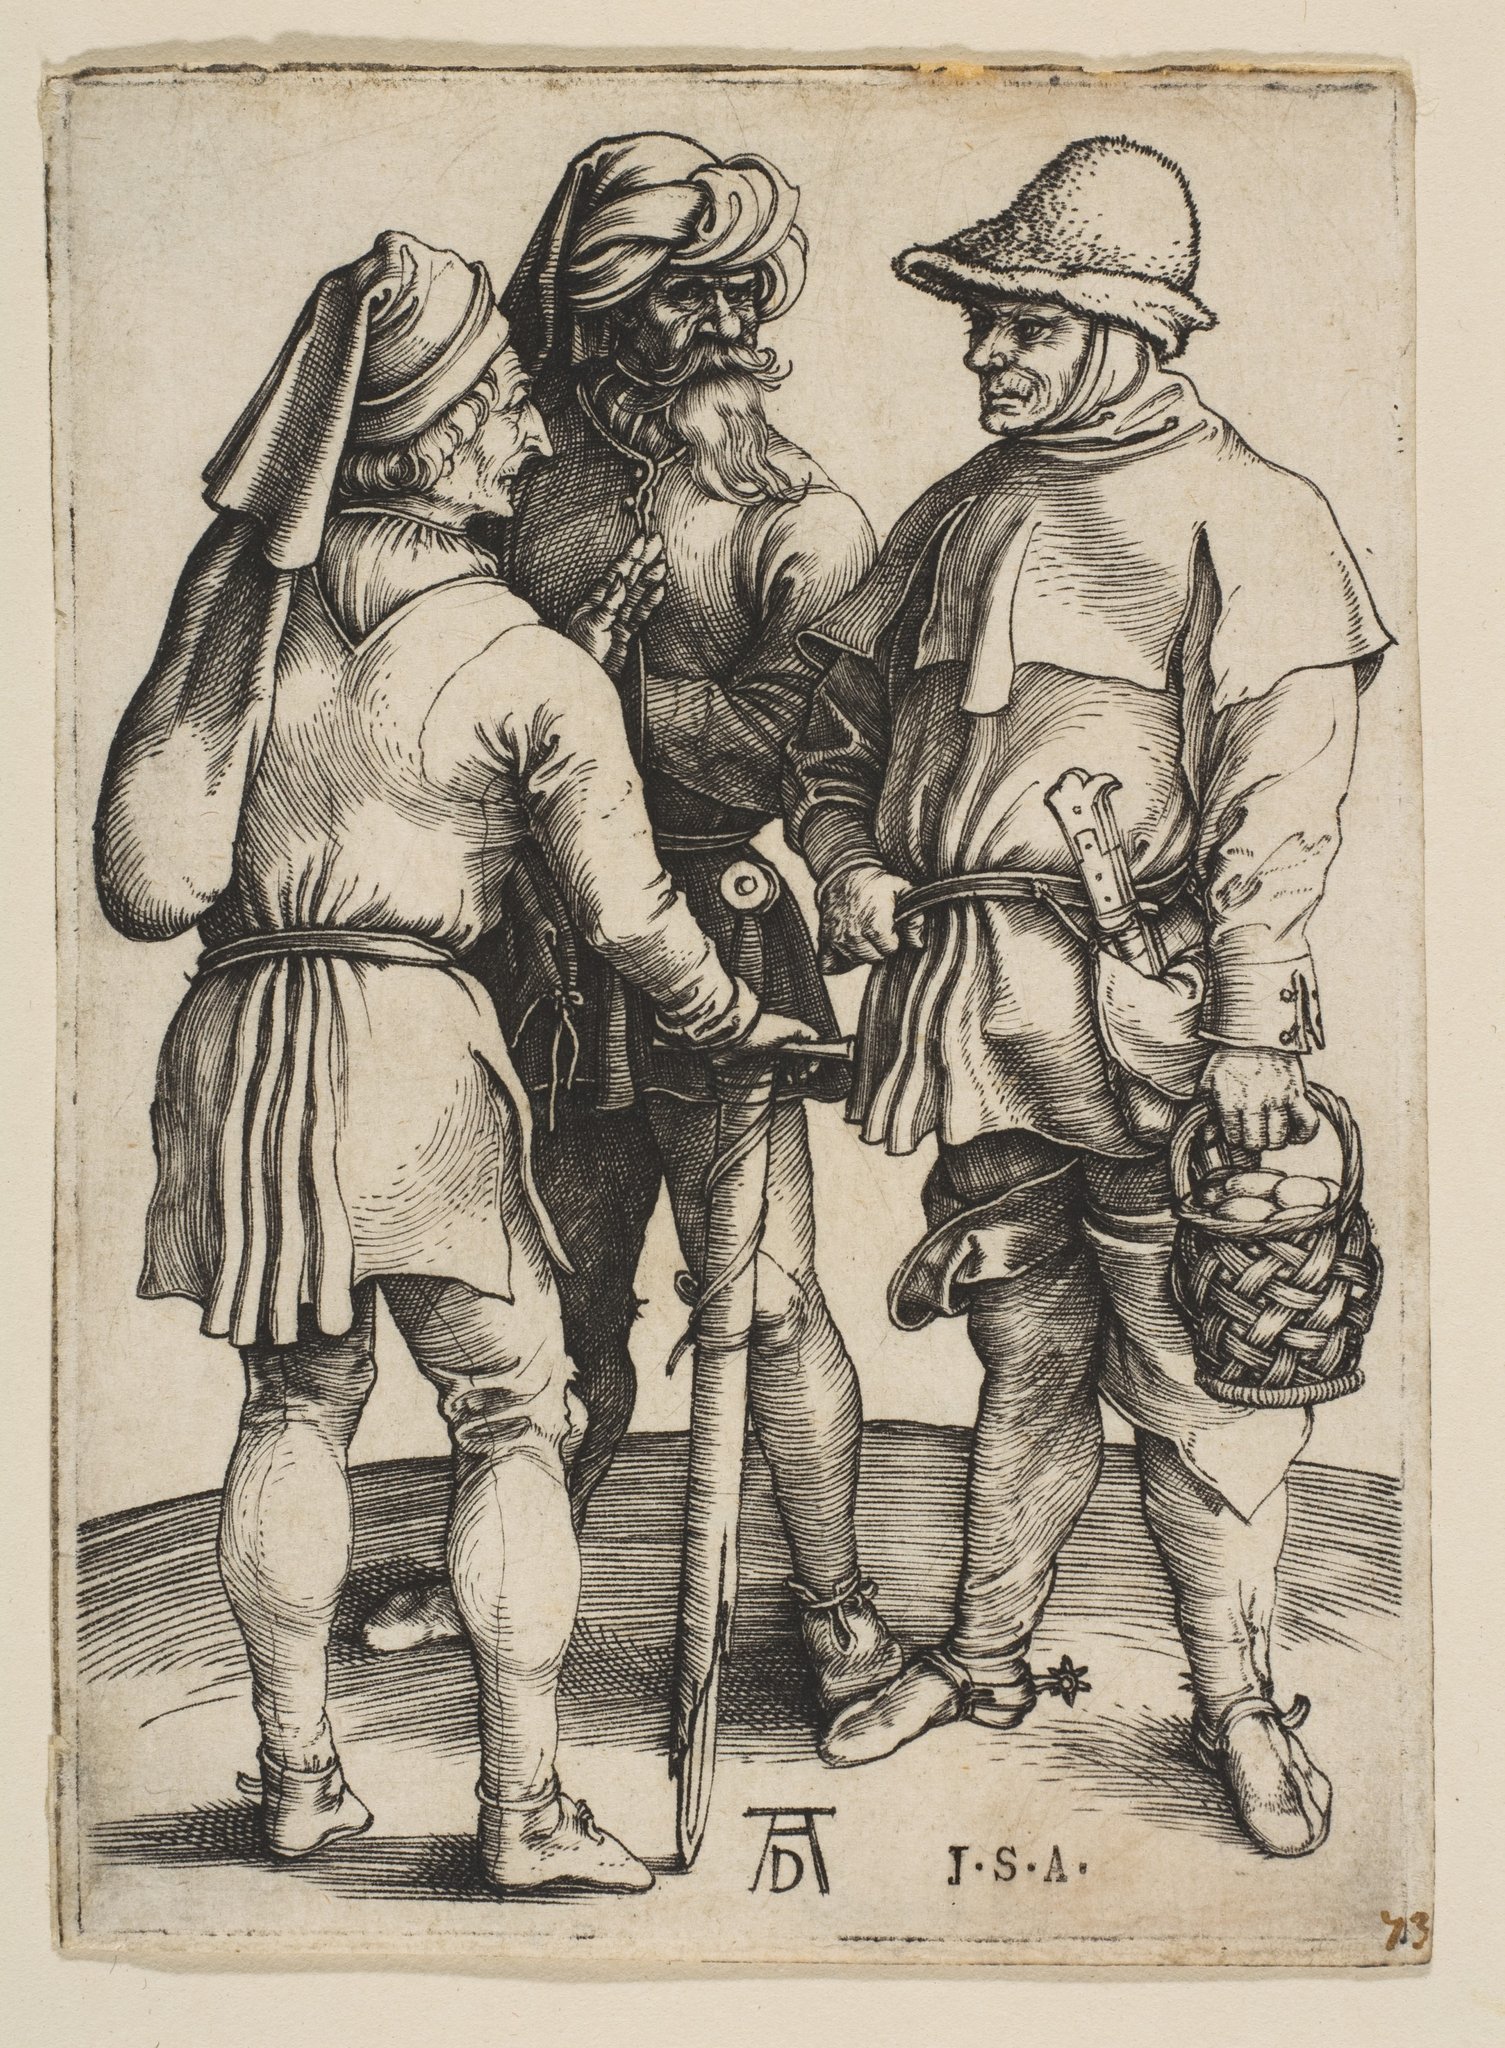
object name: print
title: Three Peasants in Conversation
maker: albrecht dürer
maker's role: artist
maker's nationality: german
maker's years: 1471-1528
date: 1497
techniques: engraving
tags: men